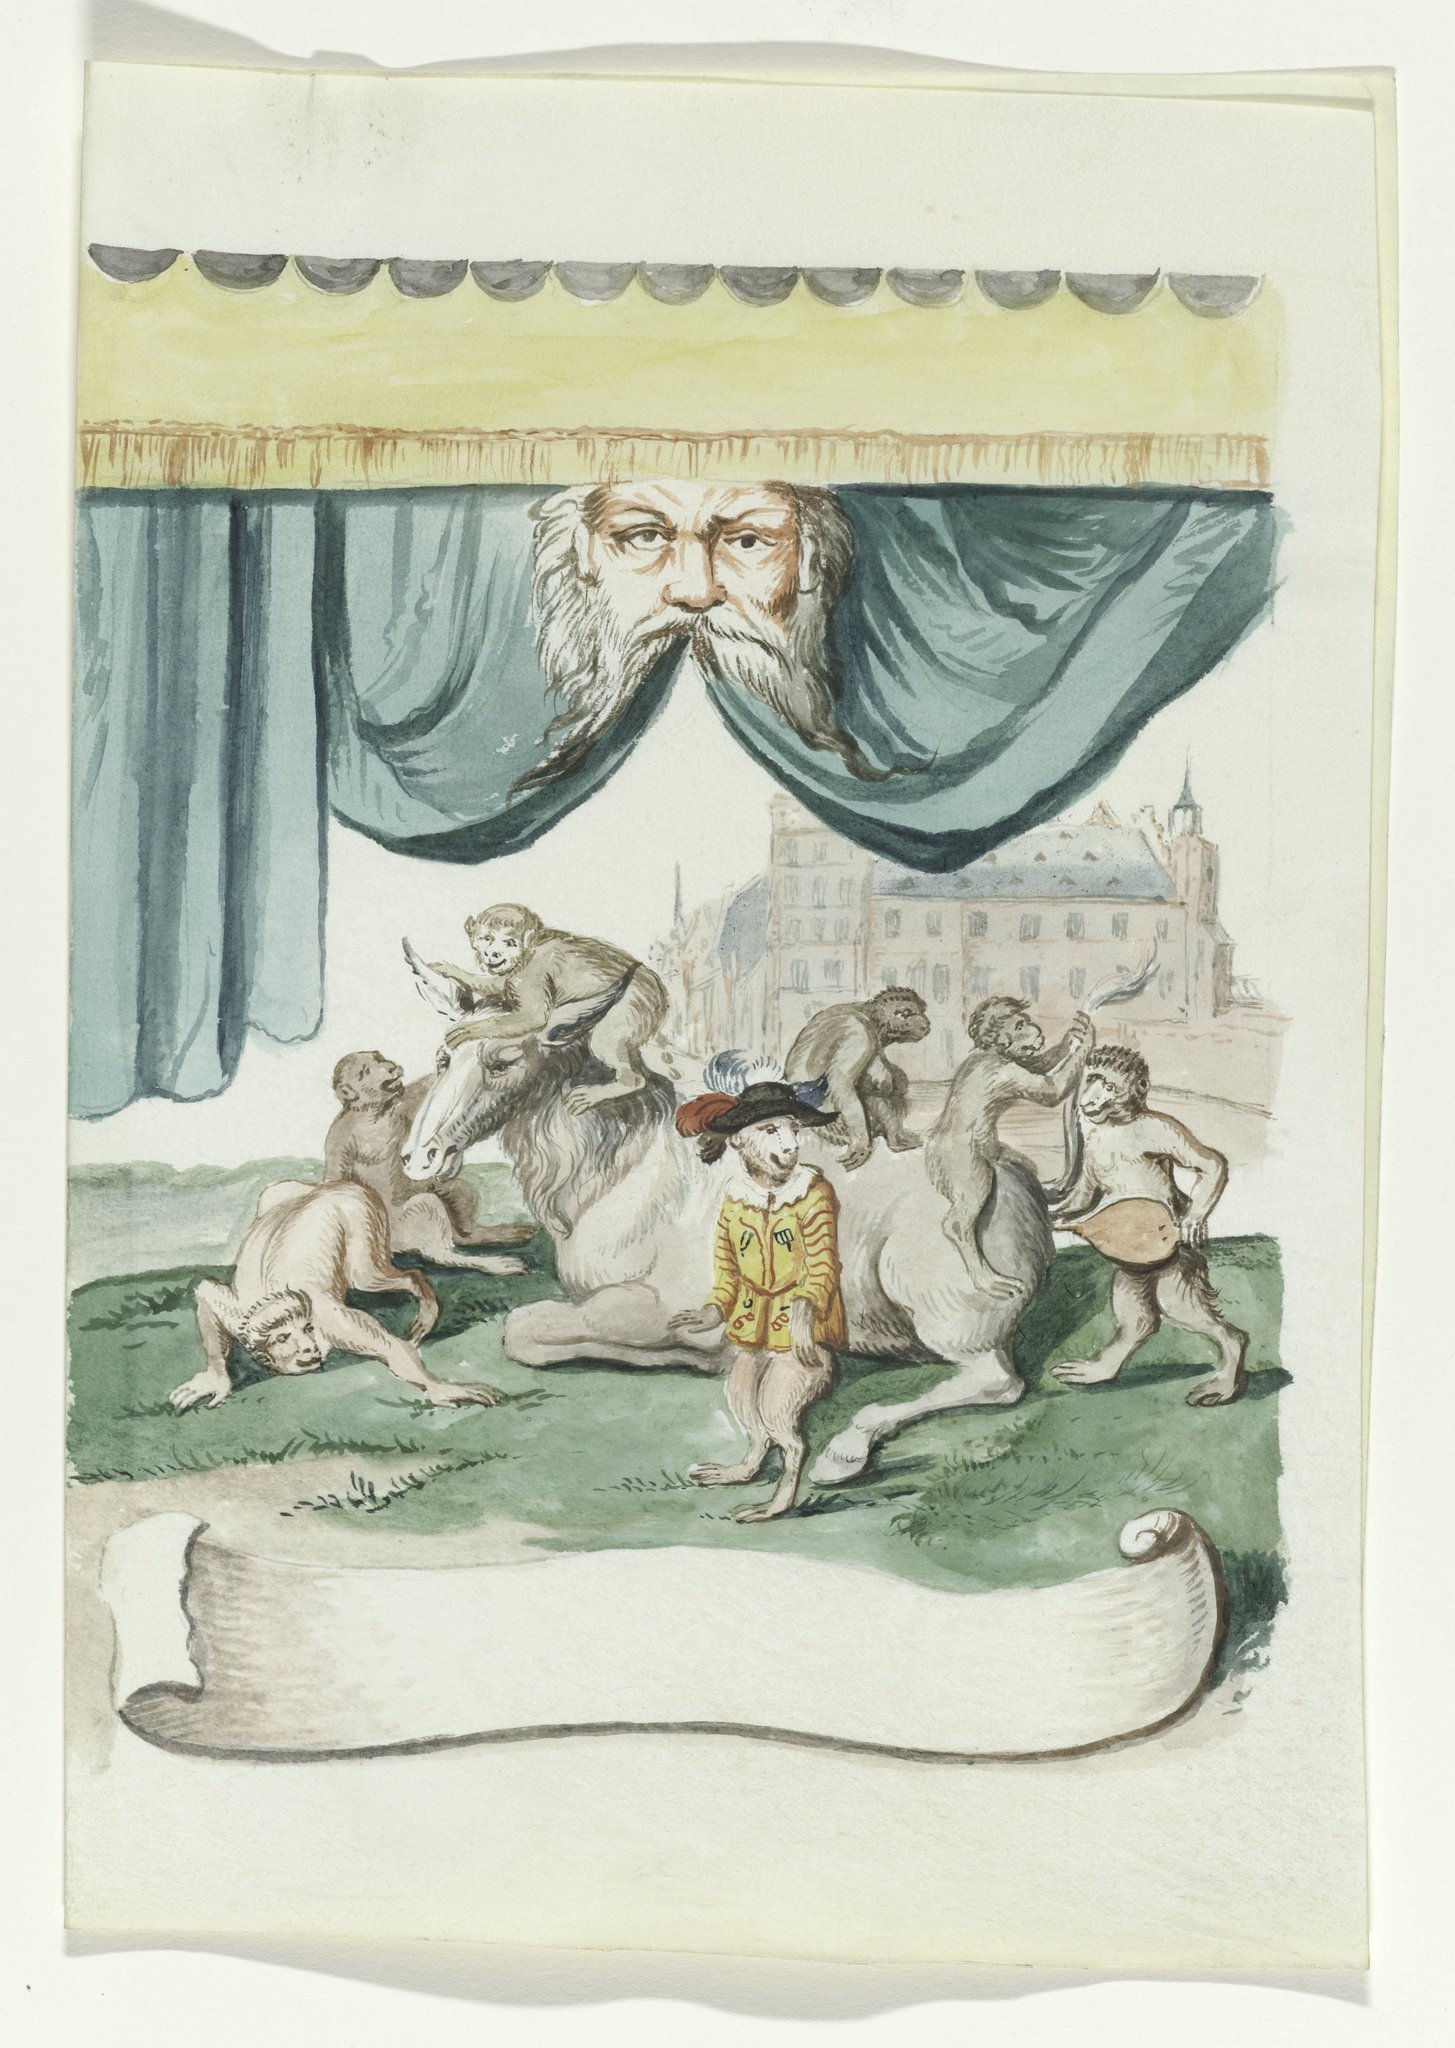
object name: cartoon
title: Regtspleging van Oldenbarnevelt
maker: Anonymous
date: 1710-1740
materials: ink, parchment, watercolor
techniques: brush, pen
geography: netherlands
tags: the hague, johan van oldenbarnevelt, ass, donkey, monkeys, apes, caricatures (human types), bad, corrupt judge, political caricatures and satires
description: Spotprent waarop podium met daarop een ezel waaromheen zeven apen. Op de achtergrond het Binnenhof. Met handgeschreven tekst. Behorende bij serie aquarellen in boek.